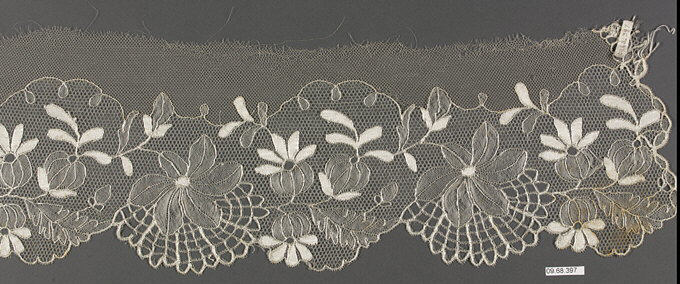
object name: bobbin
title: Silk bobbin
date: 1801-1833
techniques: lace